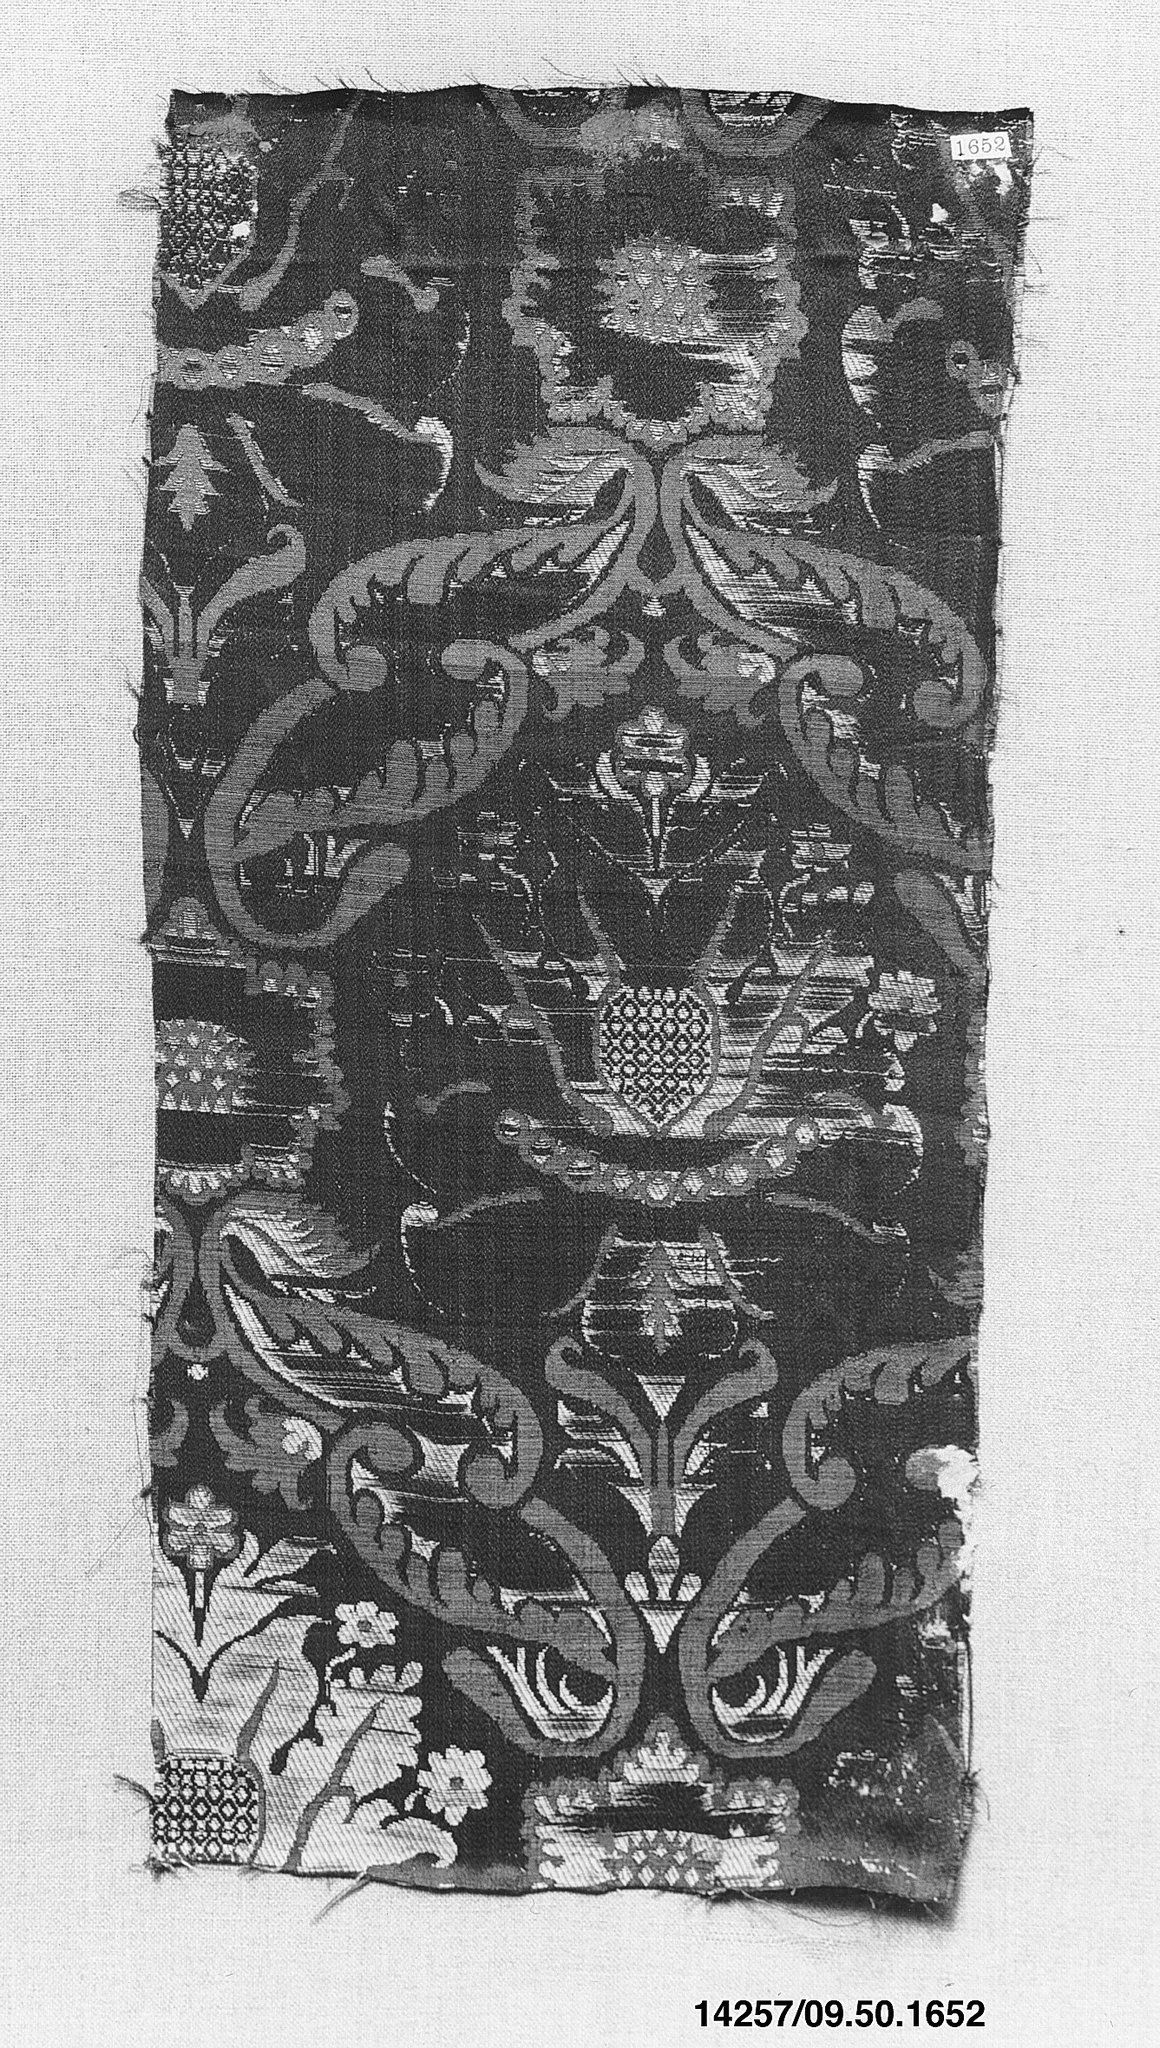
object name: piece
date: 1601-1700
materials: silk